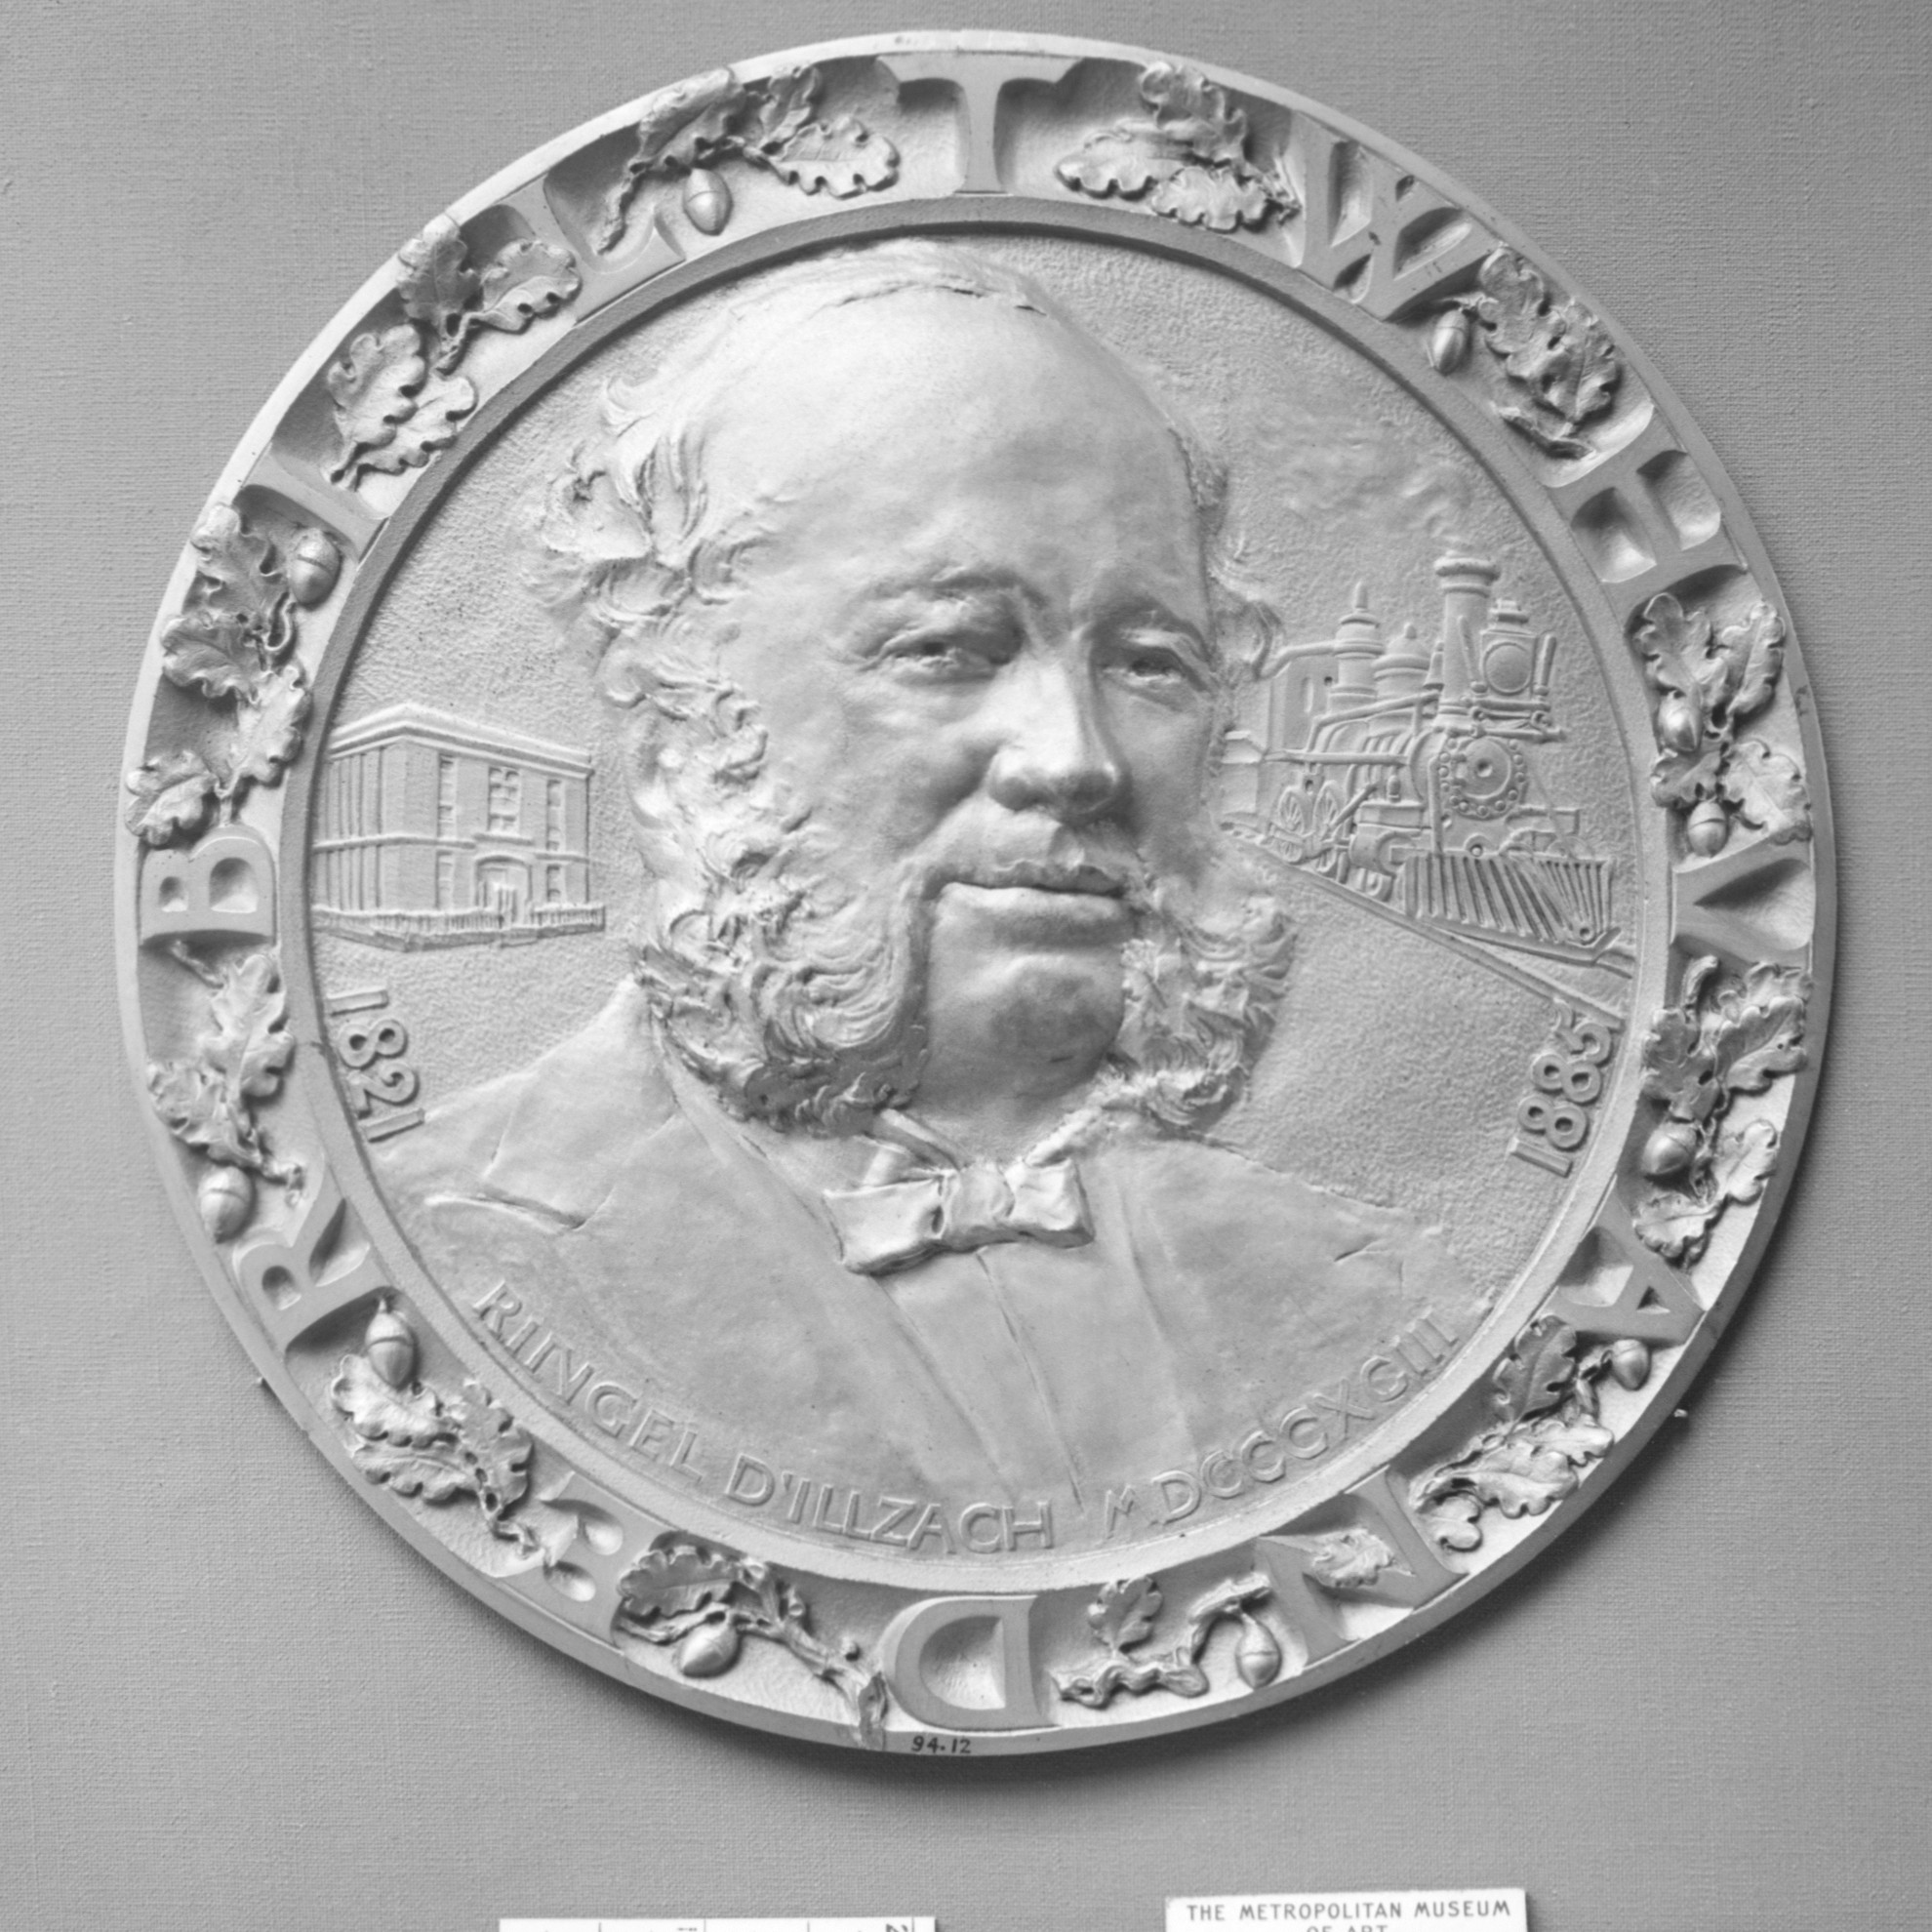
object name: medallion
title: Portrait of W.H. Vanderbilt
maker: jean-désiré ringel d'illzach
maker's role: artist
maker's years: 1847-1916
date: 1893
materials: gilt bronze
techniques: struck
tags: men,portraits,trains